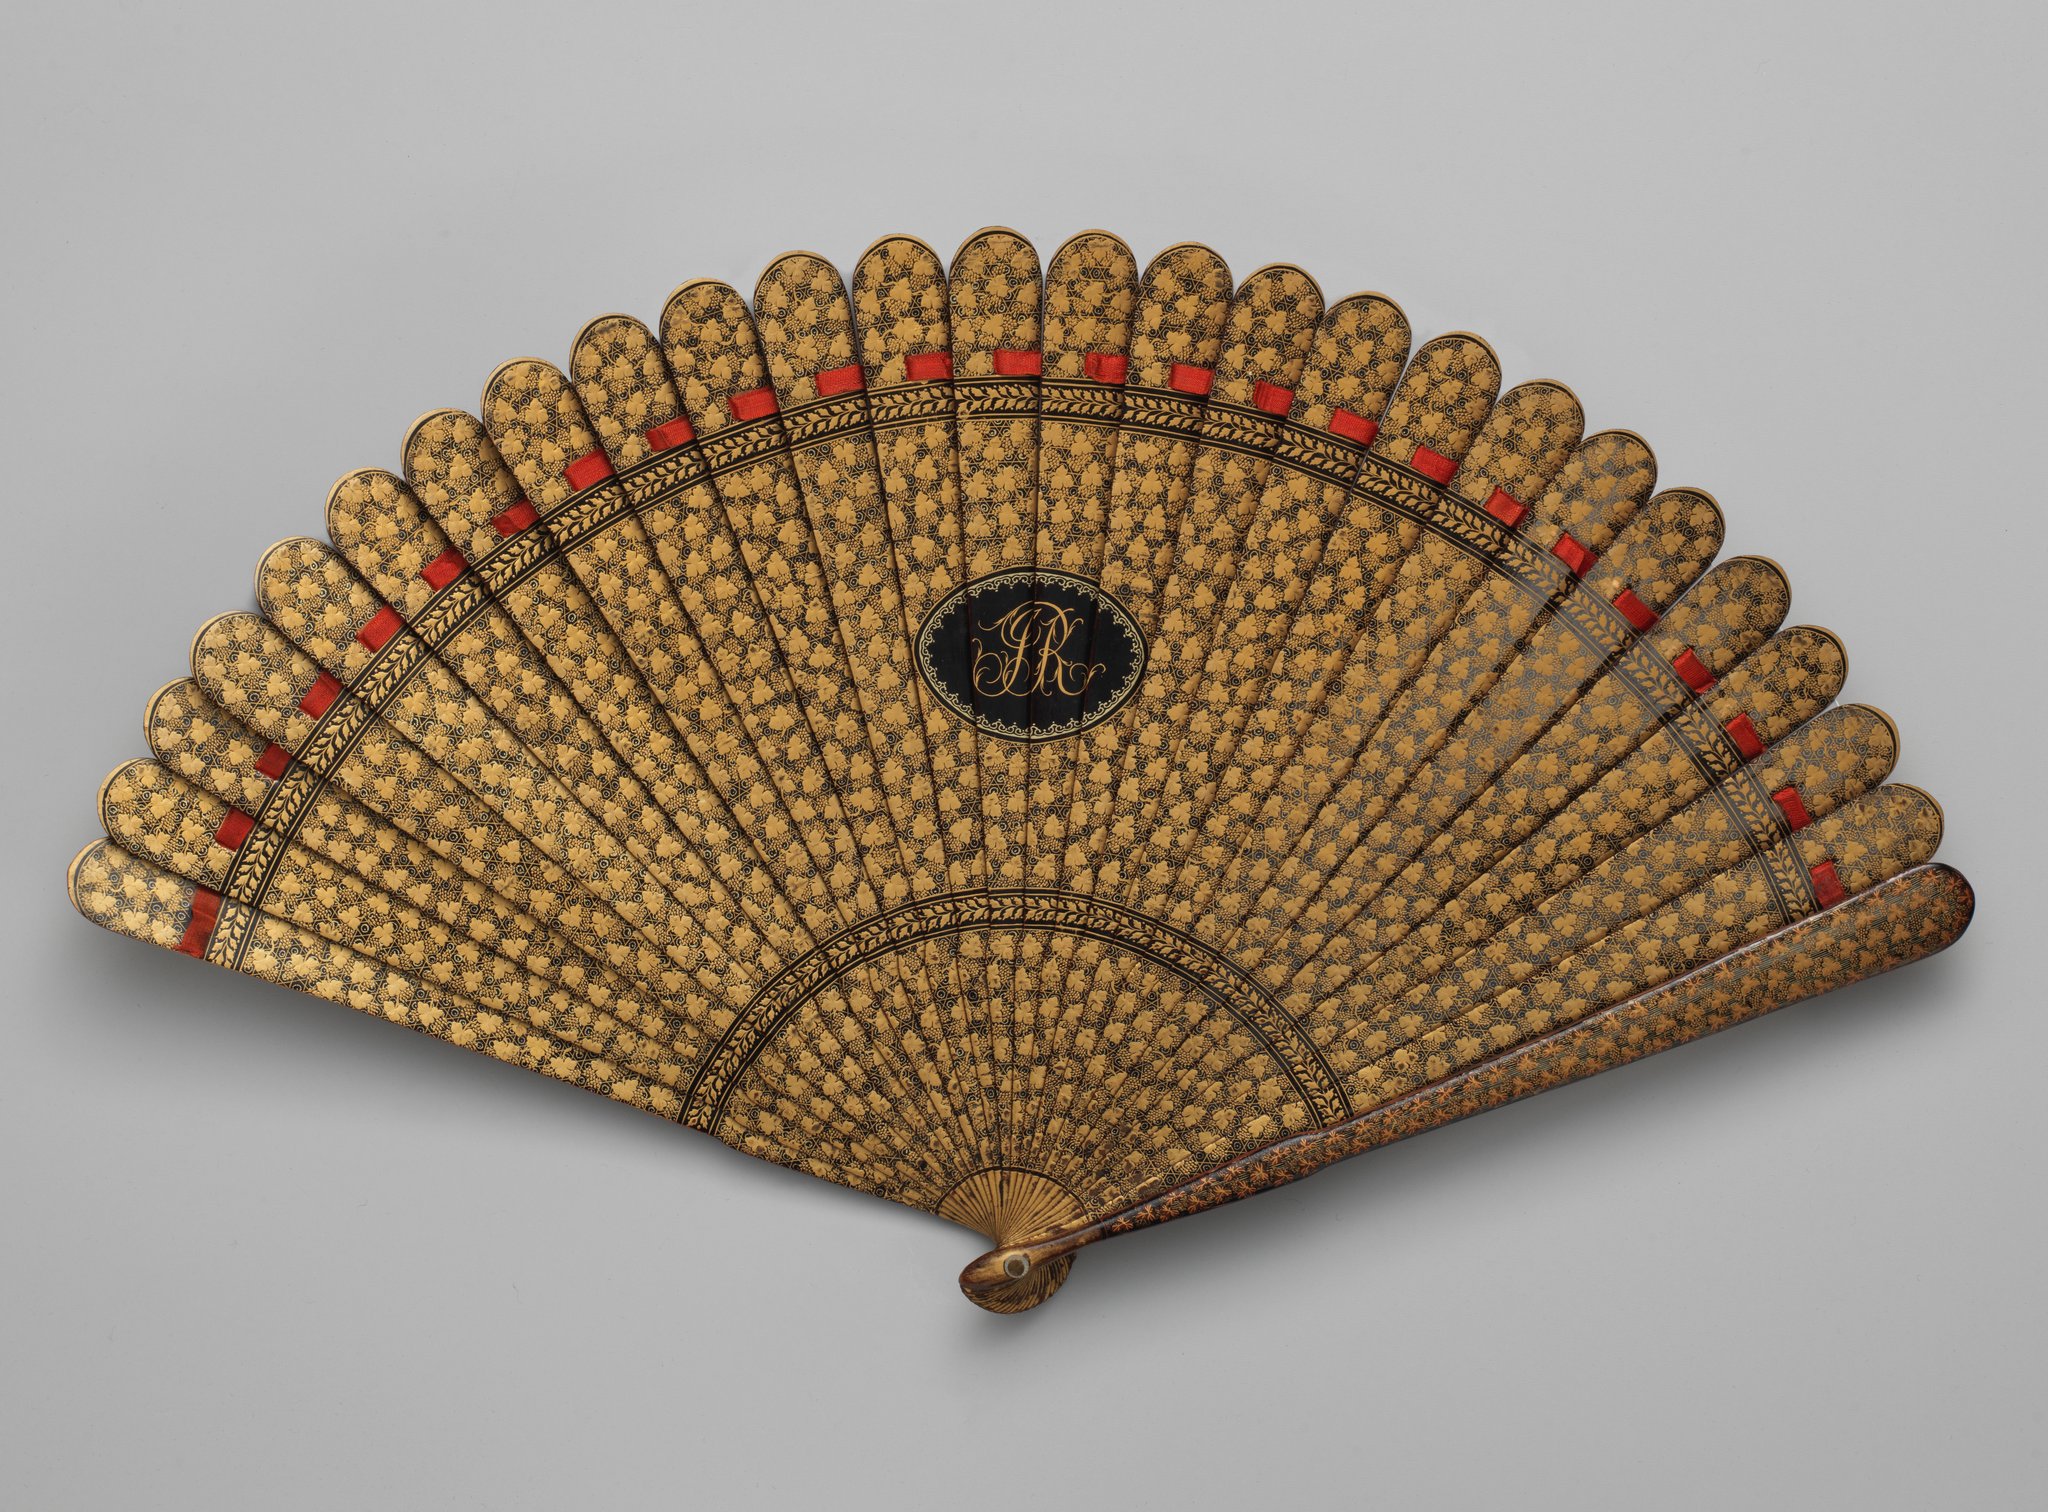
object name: fan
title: Brisé Fan, with IR monogram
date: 1801-1900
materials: metal, mother of pearl, wood